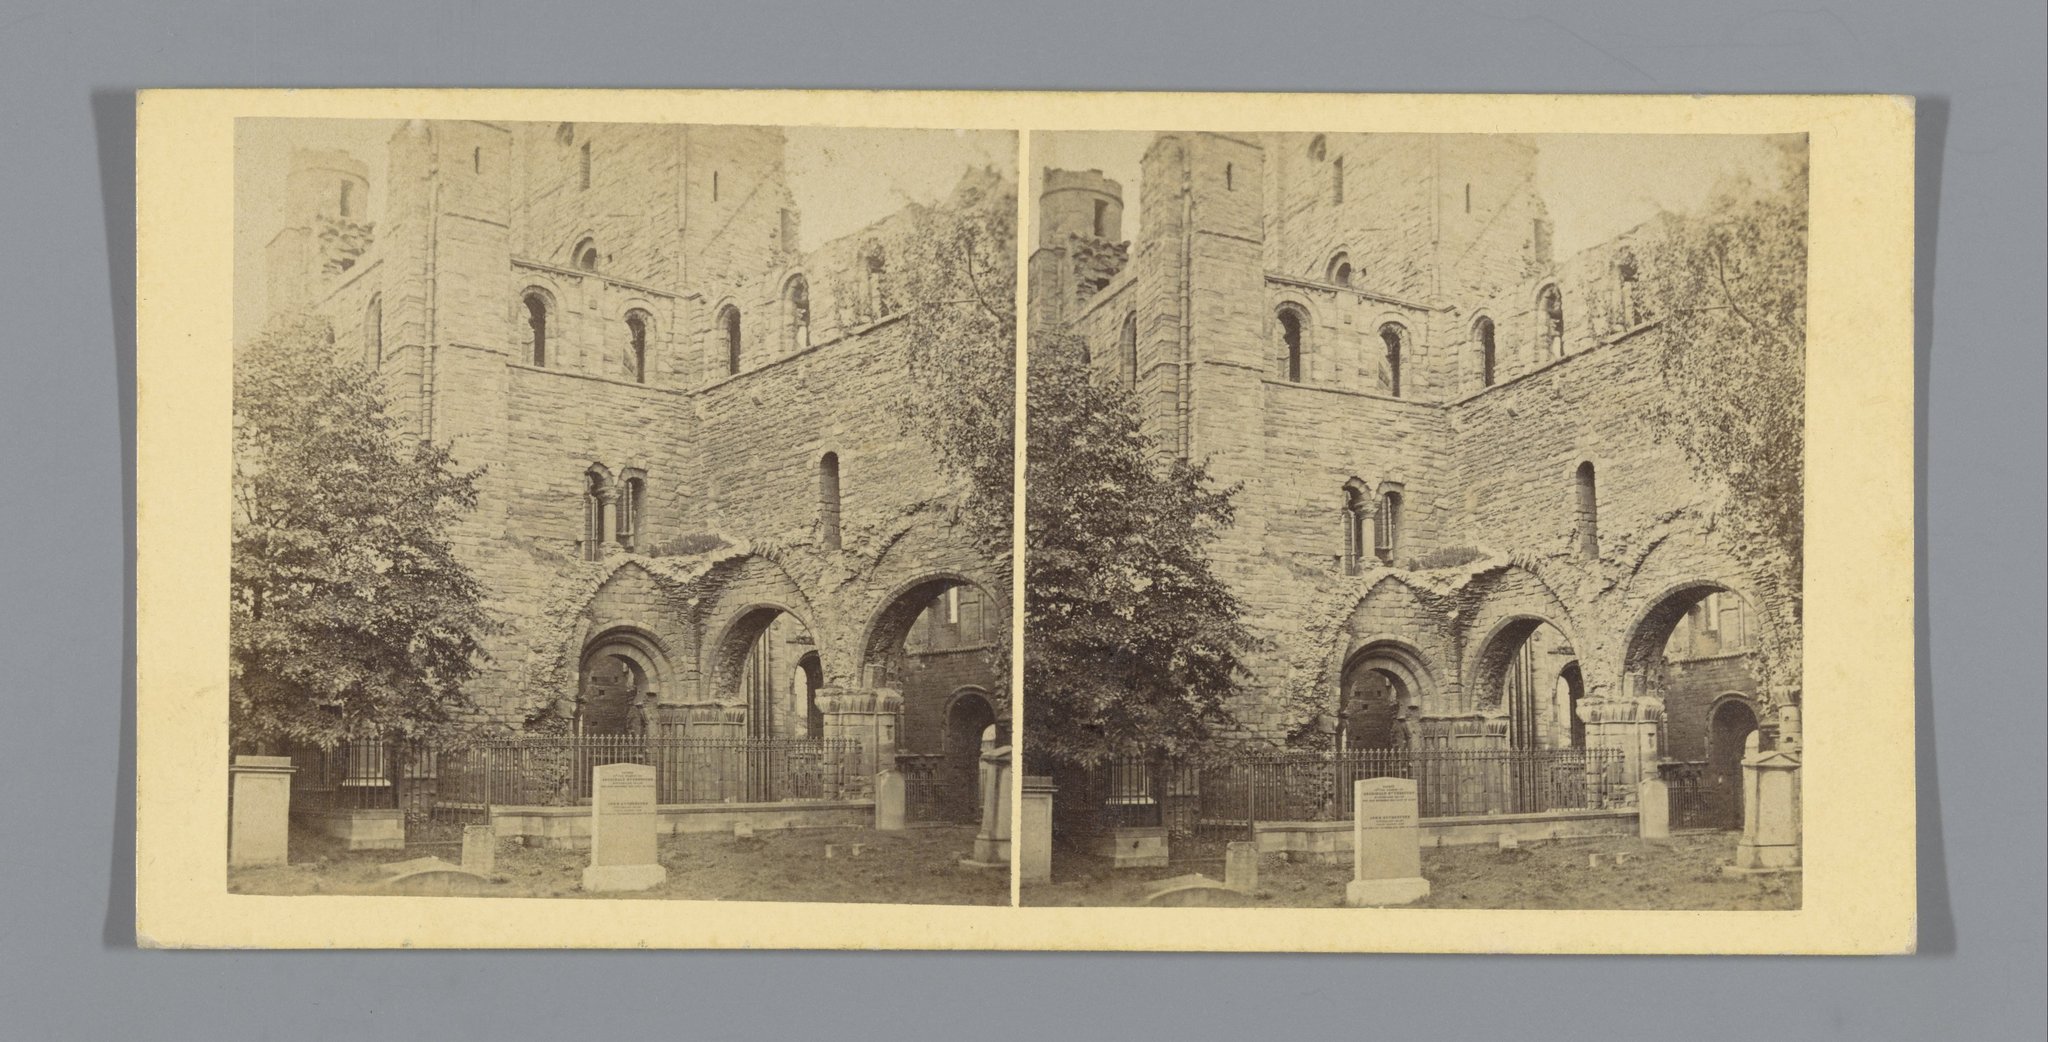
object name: stereograph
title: Gezicht op Kelso Abbey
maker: Anonymous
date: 1850-1880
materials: cardboard, photographic support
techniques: albumen print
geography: kelso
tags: abbey, monastery, convent ~ roman catholic church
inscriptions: number: ‘215. B’, inscription: ‘Kelso Abbey (...)’